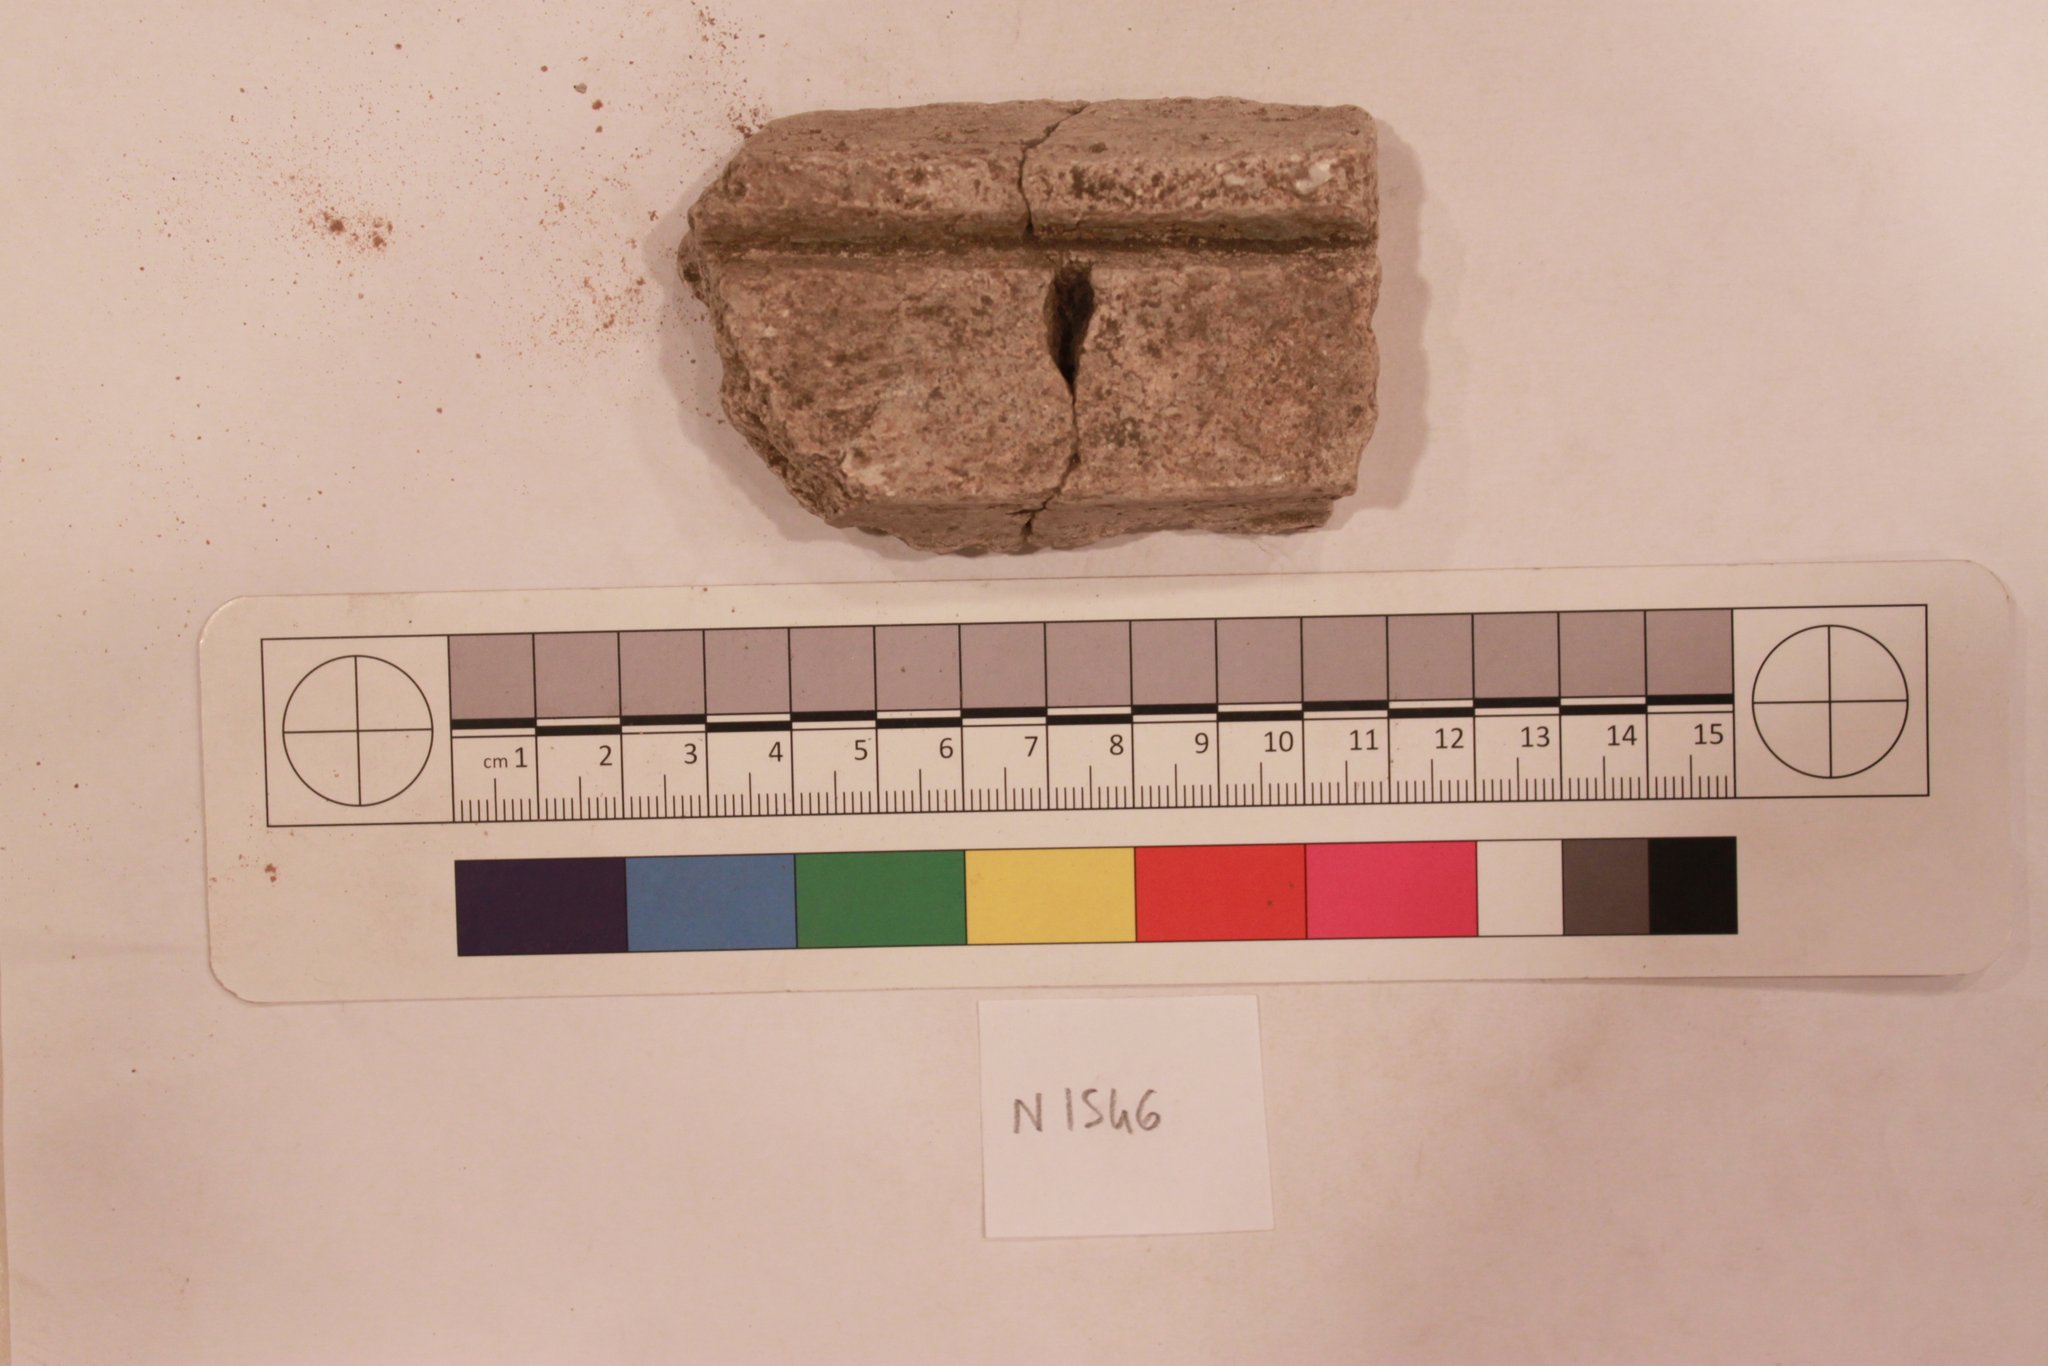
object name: fragment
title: Stucco Fragment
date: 701-1200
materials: plaster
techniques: carving, painting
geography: iran